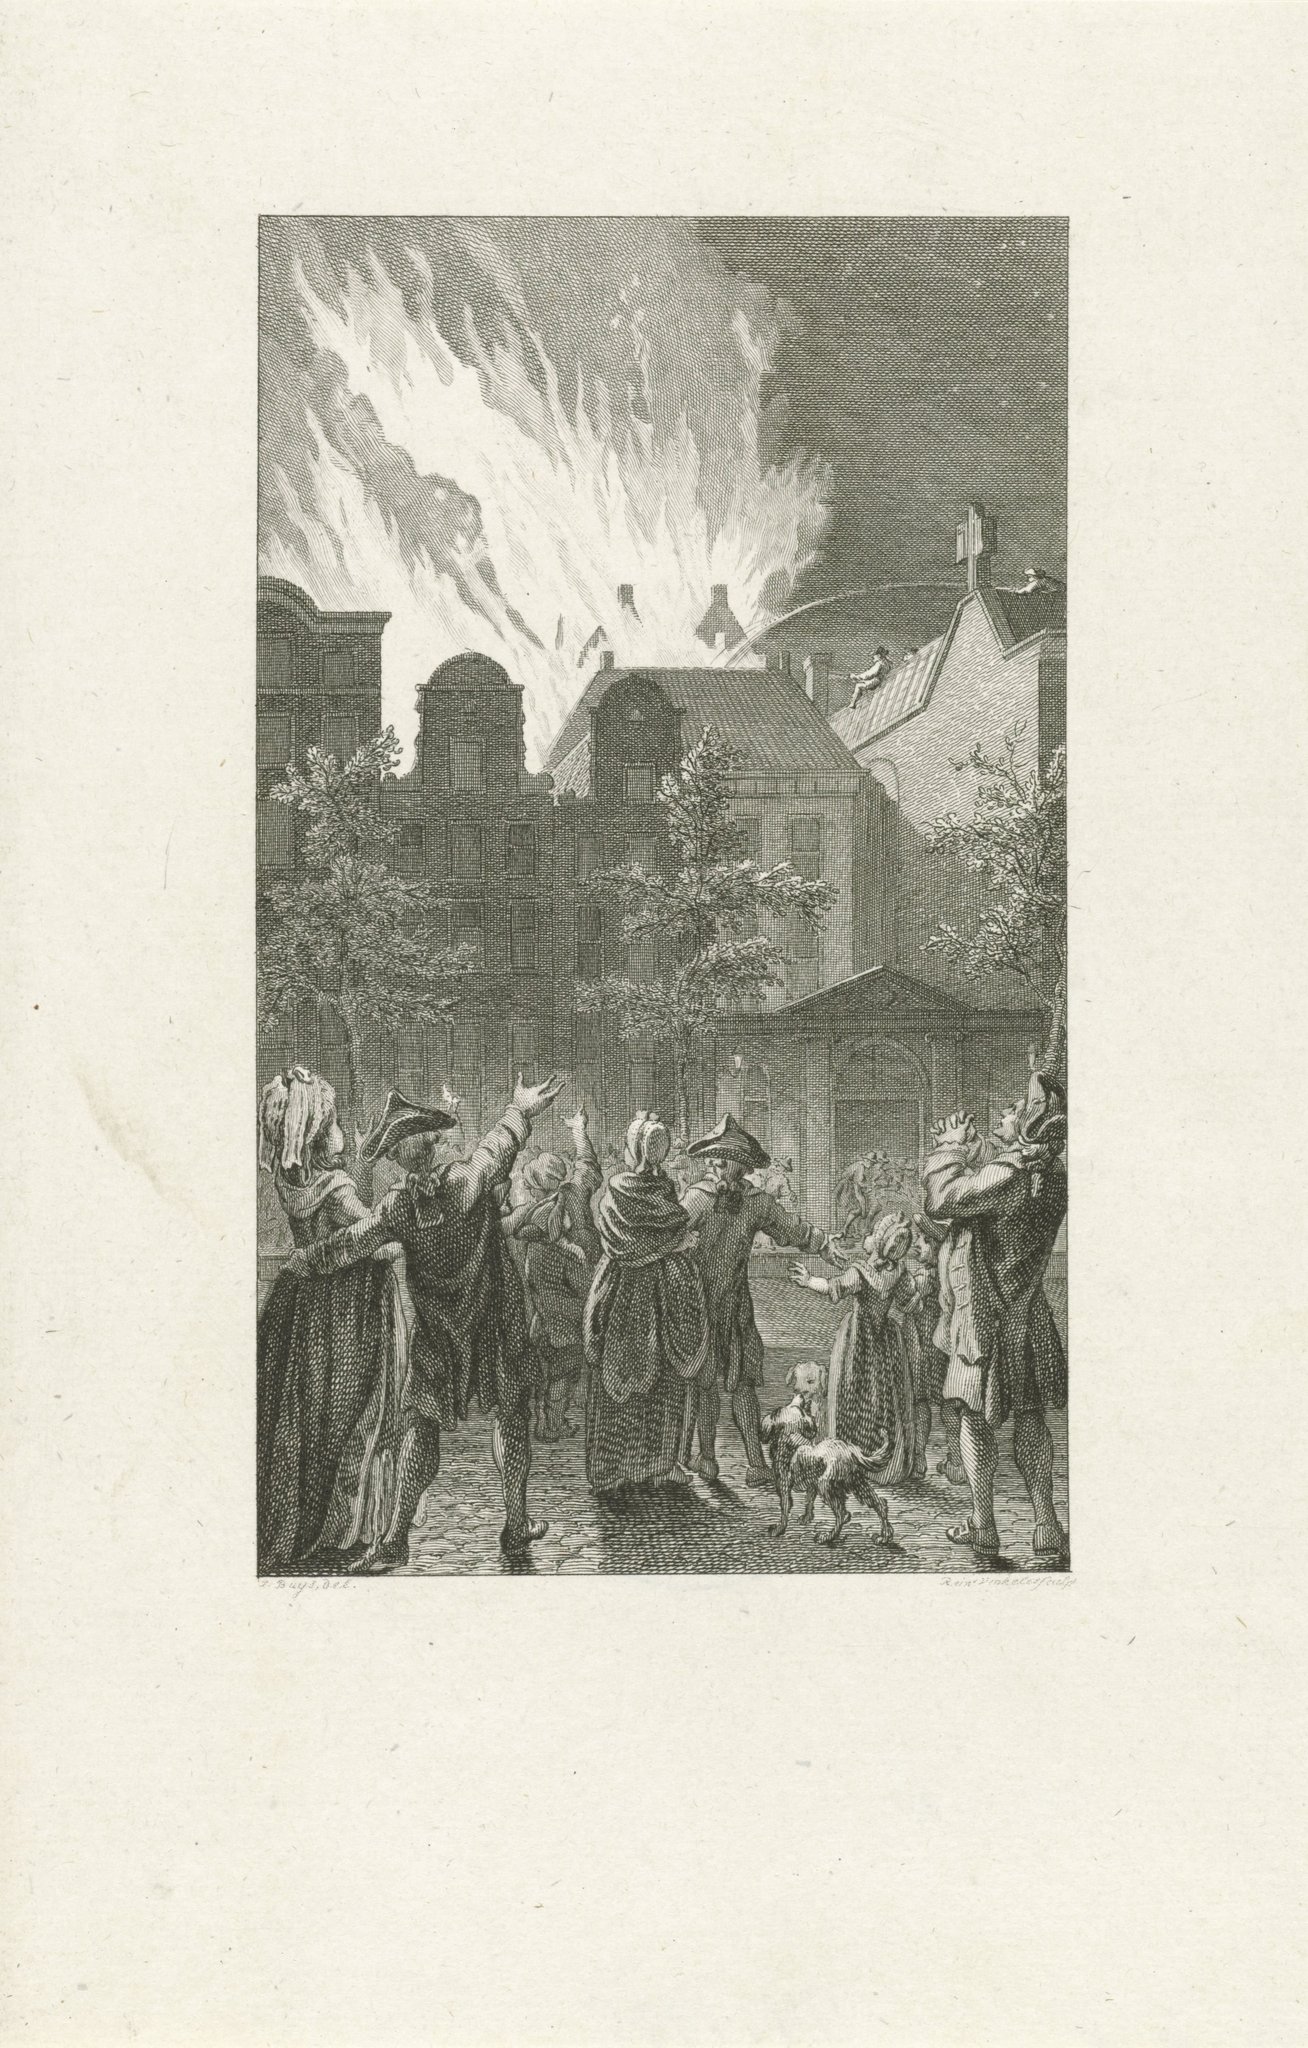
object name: print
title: Brand van de schouwburg aan de Keizersgracht te Amsterdam, 1772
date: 1786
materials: paper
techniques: engraving, etching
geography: amsterdam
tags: on fire, ablaze, theatre (building), fire-fighting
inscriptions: collector's mark: Lugt 2228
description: Gezicht op de laaiende brand in de Amsterdamse Schouwburg op 11 mei 1772, gezien vanaf de overzijde van de Keizersgracht. Vanaf het dak rechts wordt getracht het vuur te blussen. Op straat vele toeschouwers.